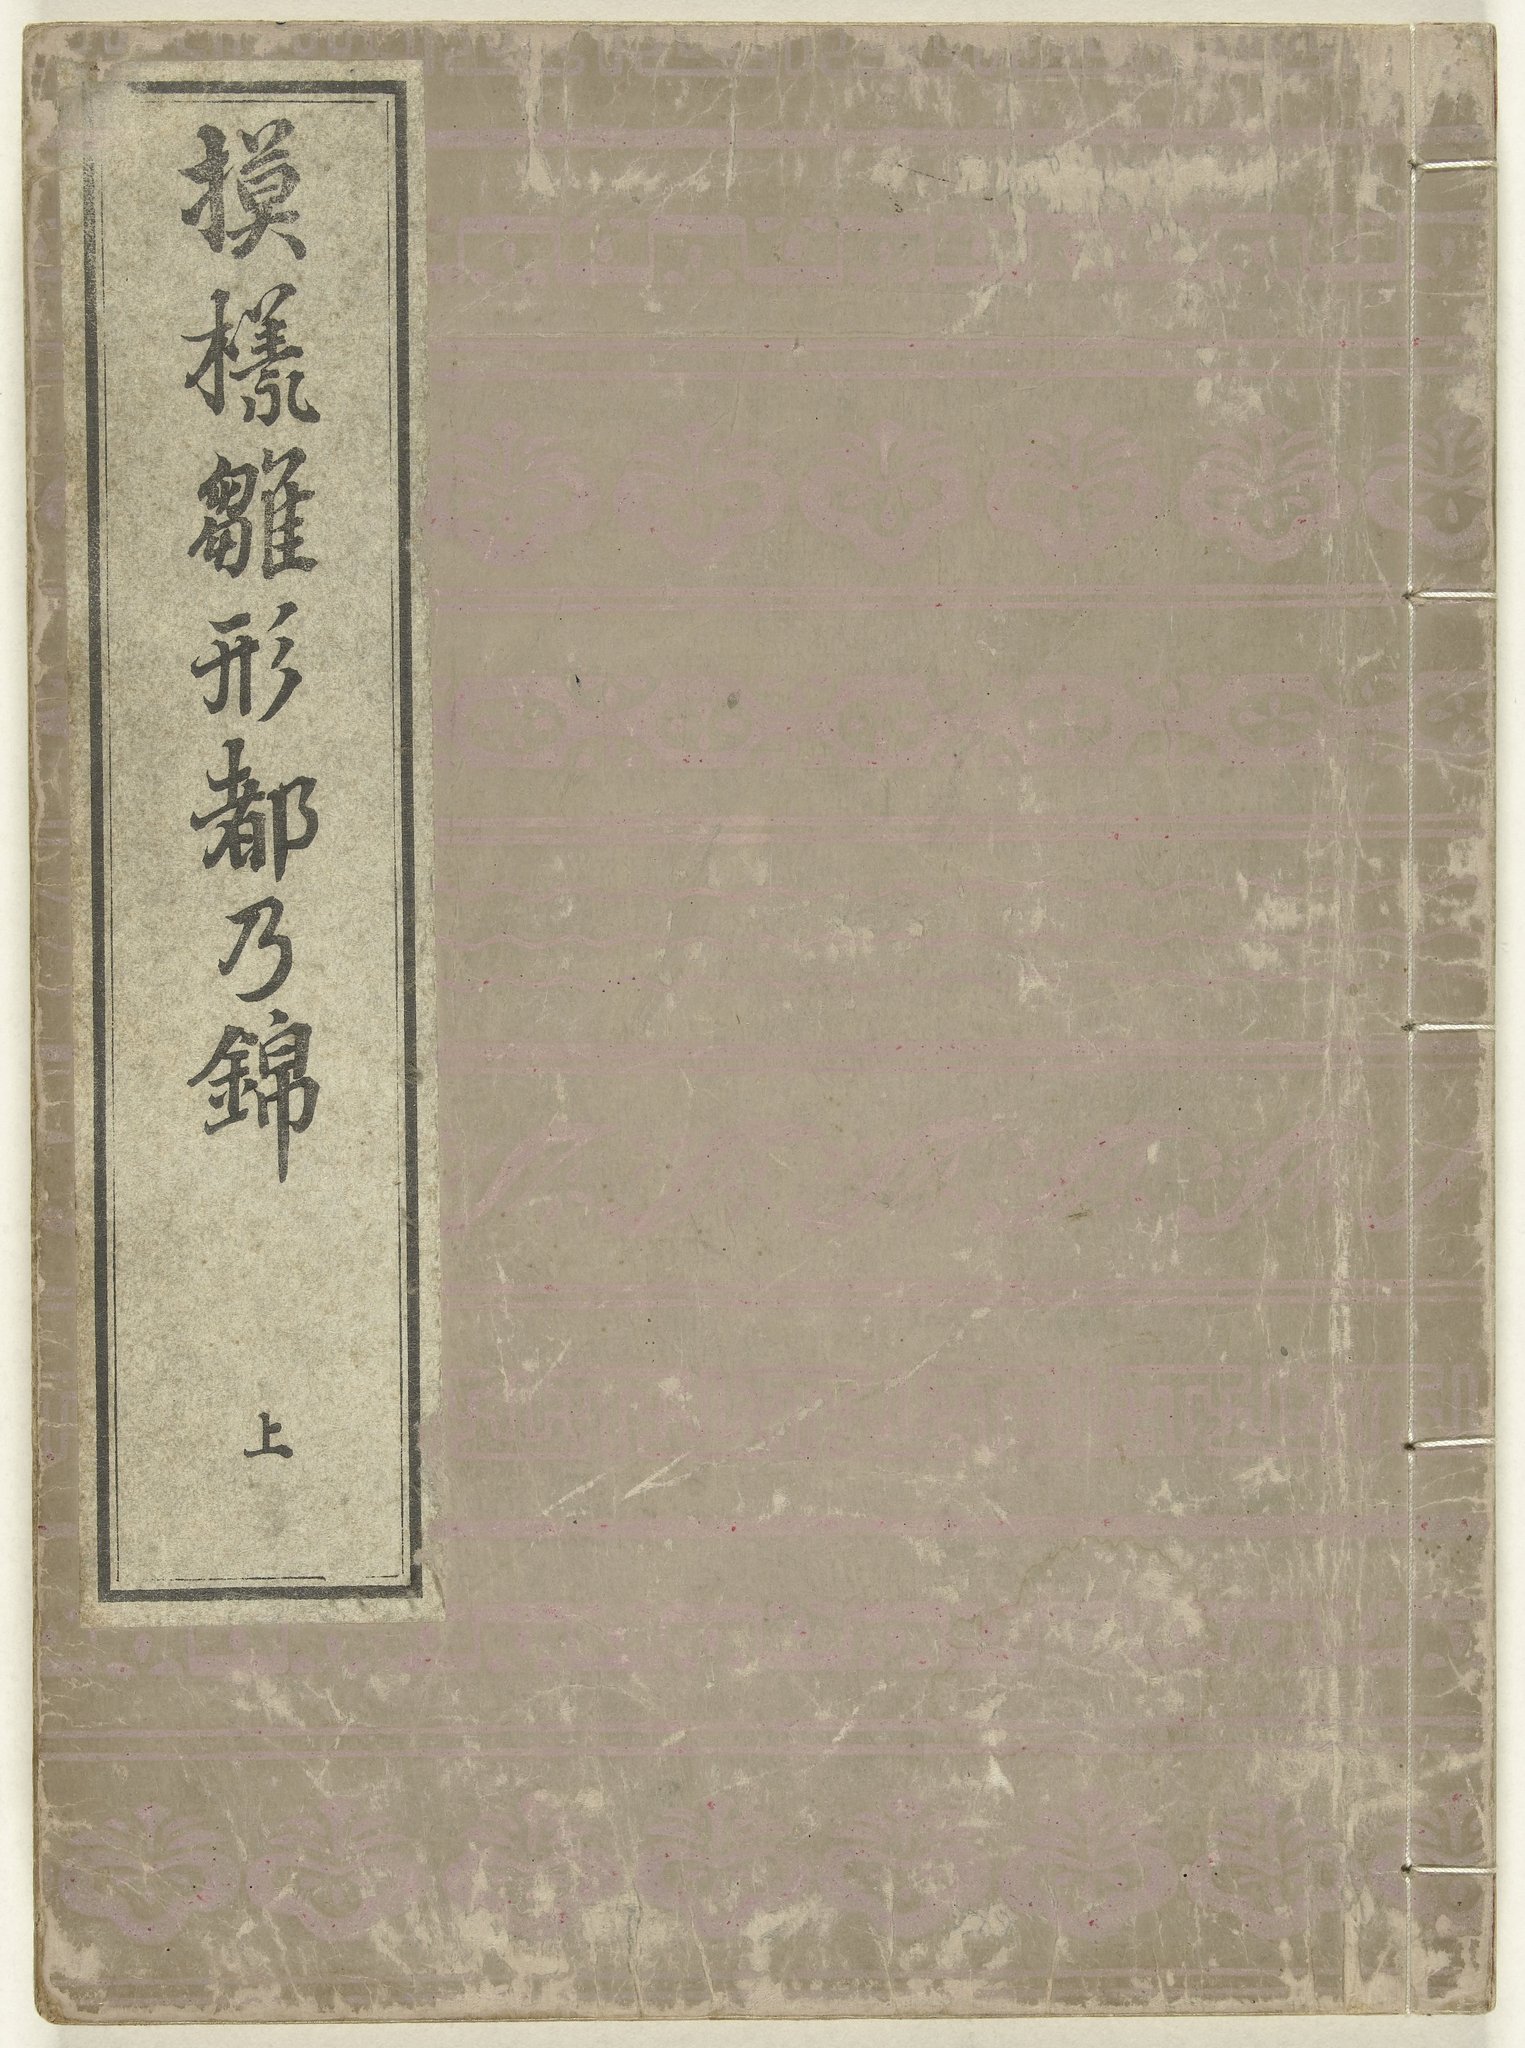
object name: book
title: Patroonmodellen voor brokaten uit de hoofdstad - één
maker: Anonymous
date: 1886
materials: paper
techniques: woodcut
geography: osaka